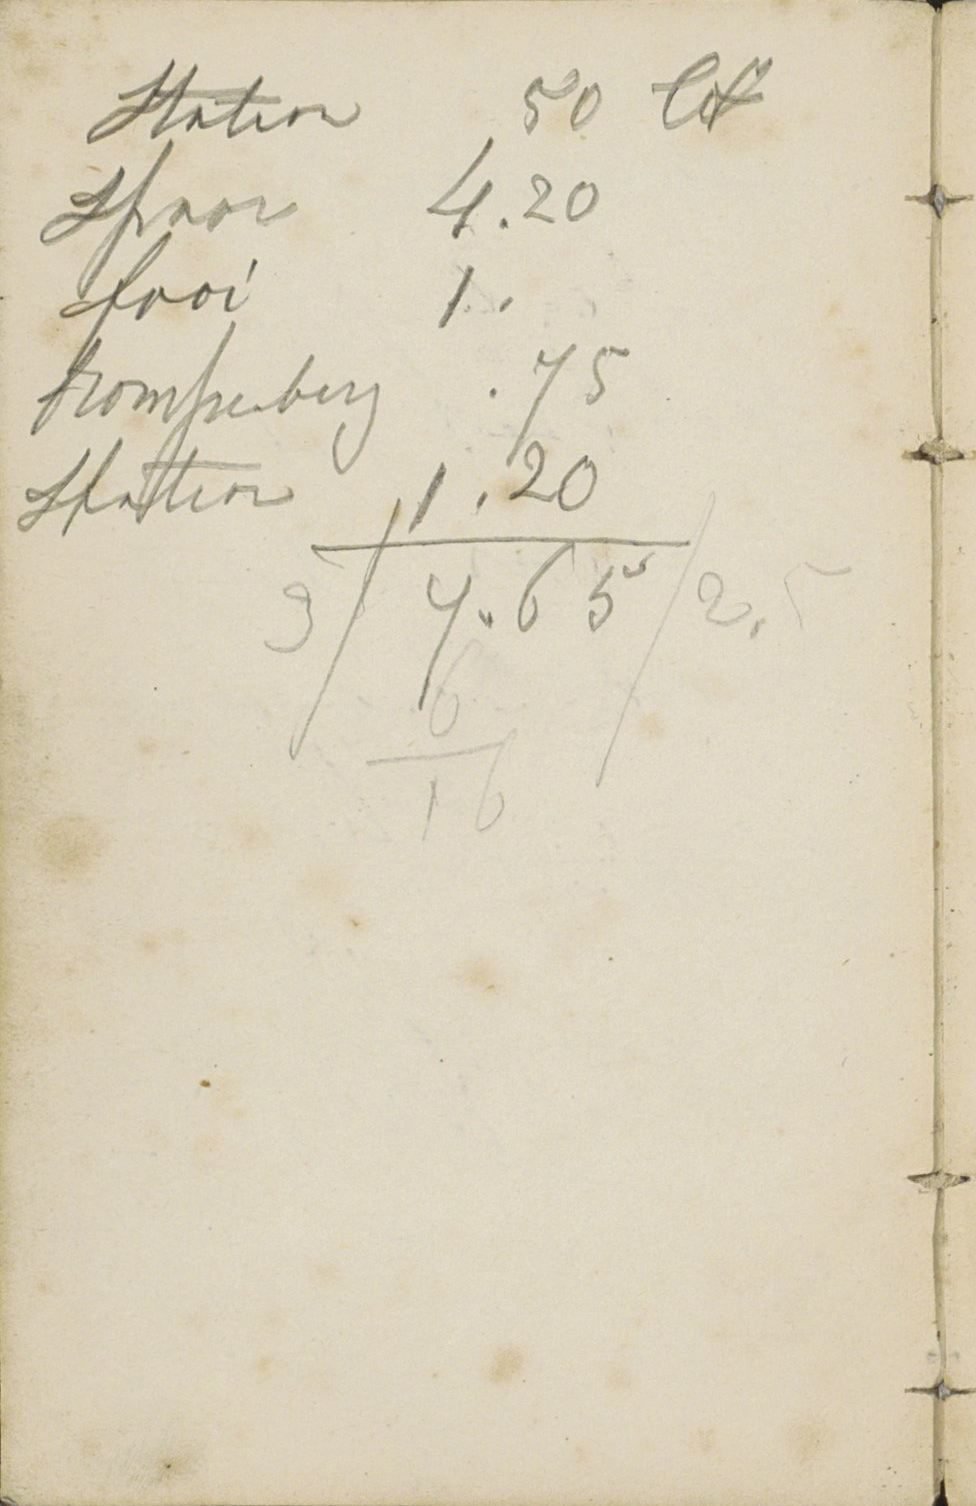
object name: sketchbook leaf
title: Lijst met uitgaven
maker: willem koekkoek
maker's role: draughtsman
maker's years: 1839-1895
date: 1849-1895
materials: paper, pencil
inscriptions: annotation: ‘staten 50 l[...]/ spaar 4.20/ fooi 1./ [...]ompenberg .75/ staten 1.20/ 3f 4.65/2/ 6/ 16’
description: Blad 1 verso uit een schetsboek met 57 bladen.